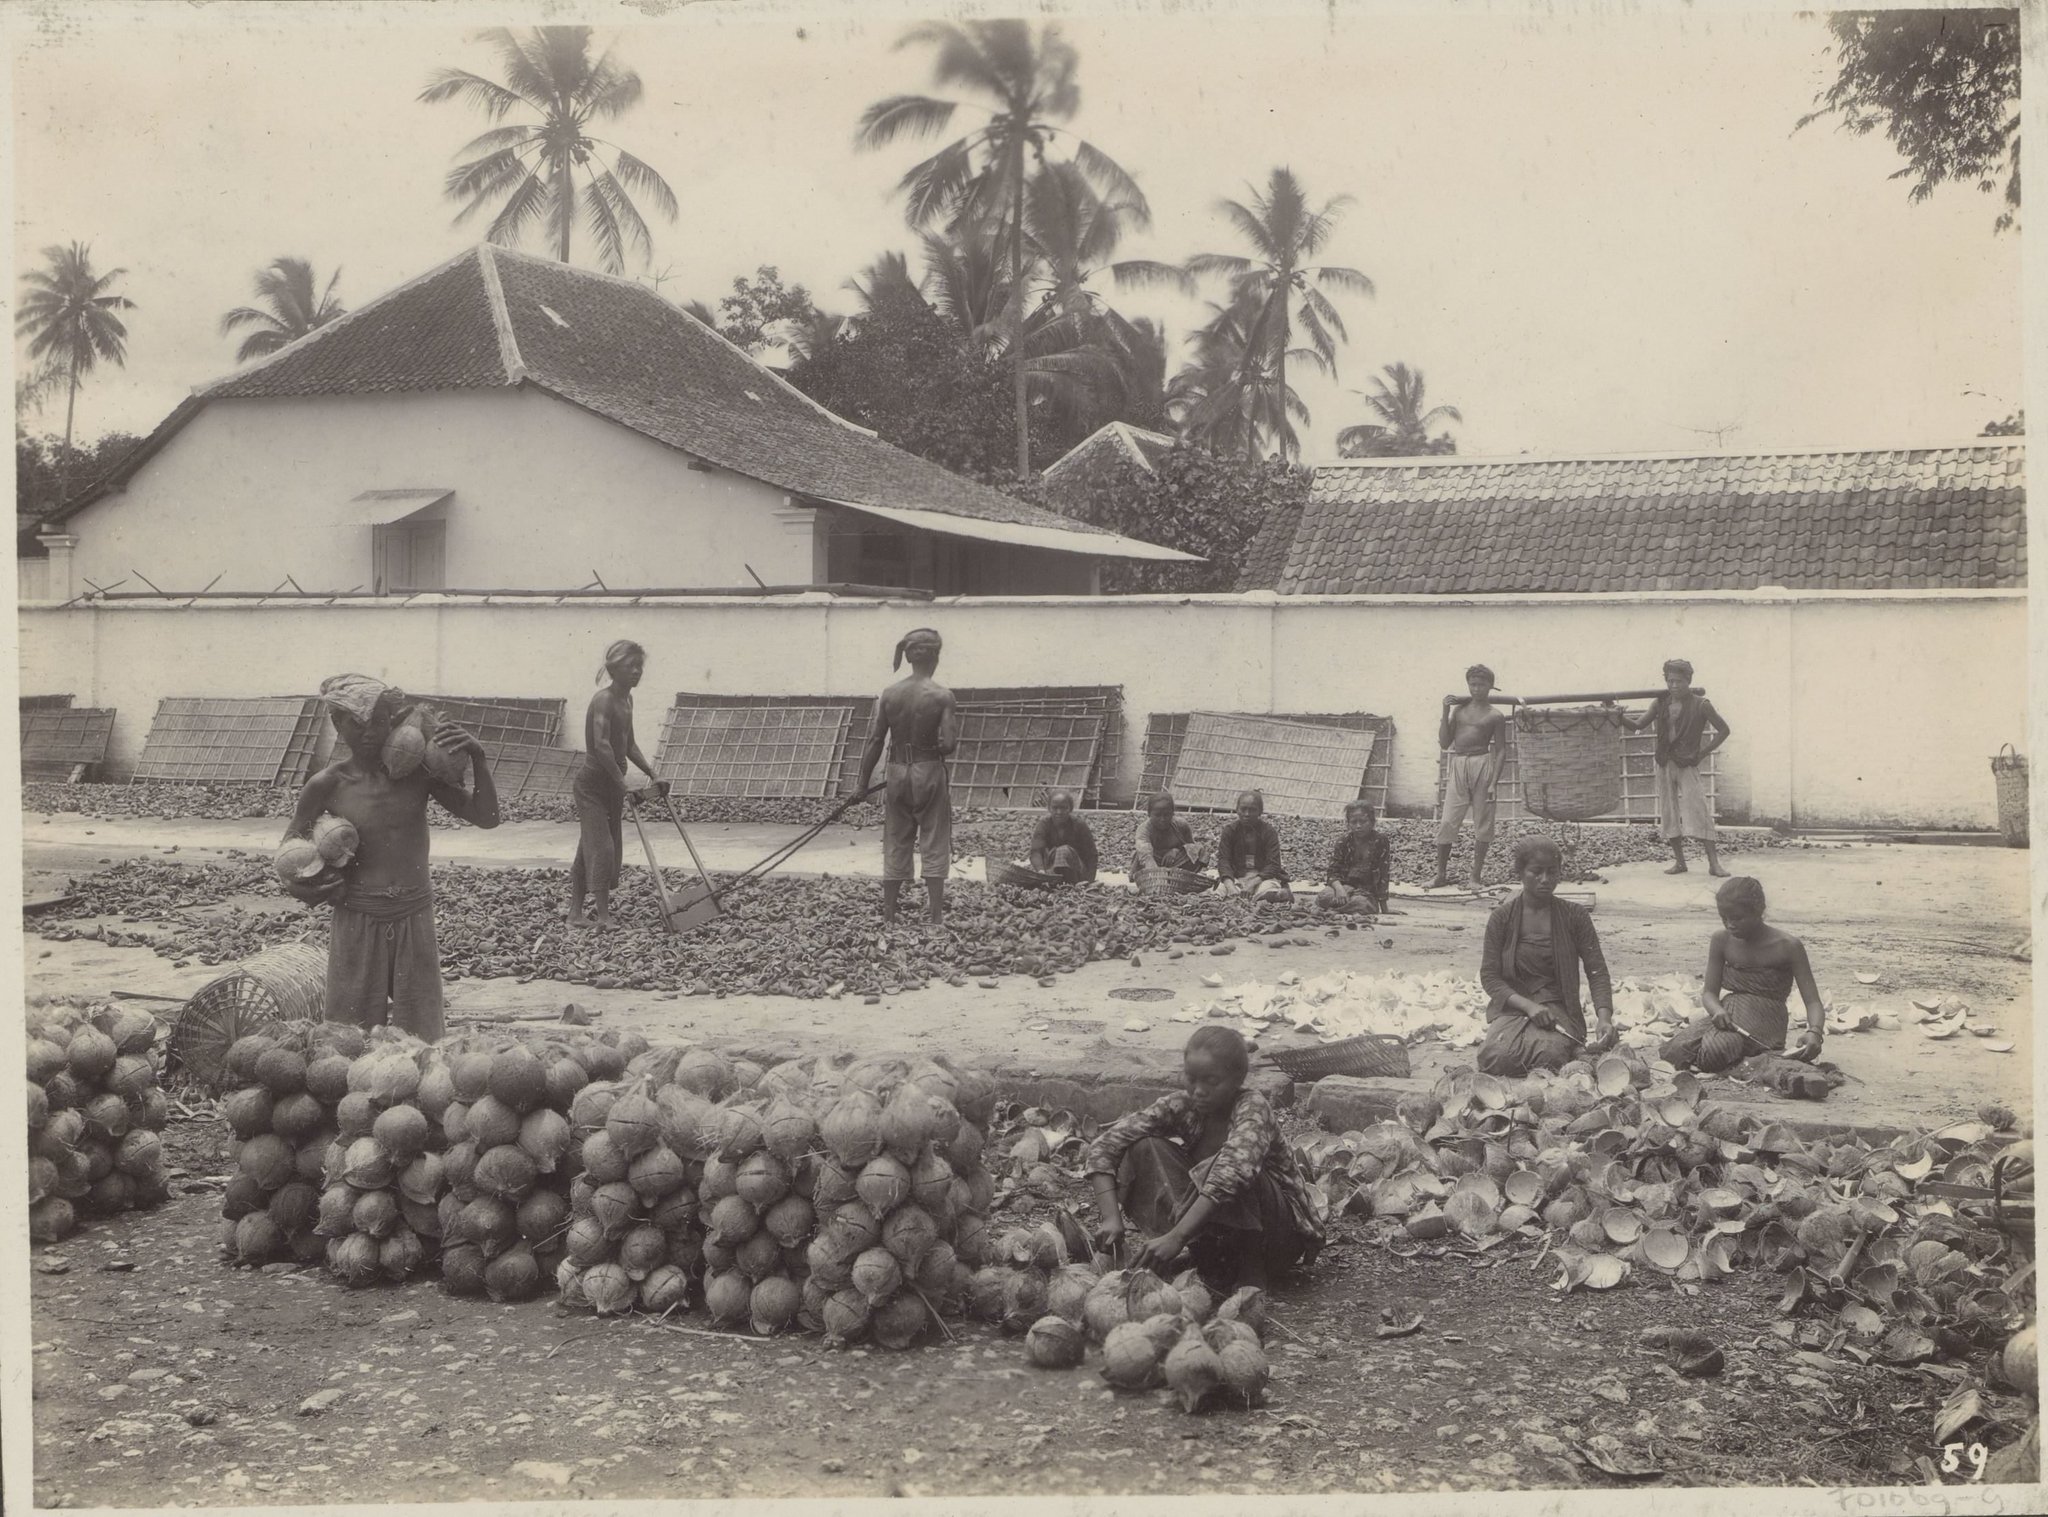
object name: photograph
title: Mannen en vrouwen bereiden kopra in Nederlands-Indië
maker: onnes kurkdjian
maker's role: fotograaf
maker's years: 1851-1903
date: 1912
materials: paper, photographic support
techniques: gelatin silver print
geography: dutch east indies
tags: agricultural products and by-products, dutch east indies, the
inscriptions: number: ‘59’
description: Onderdeel van Reisalbum met veertig foto's van Nederlands-Indië.